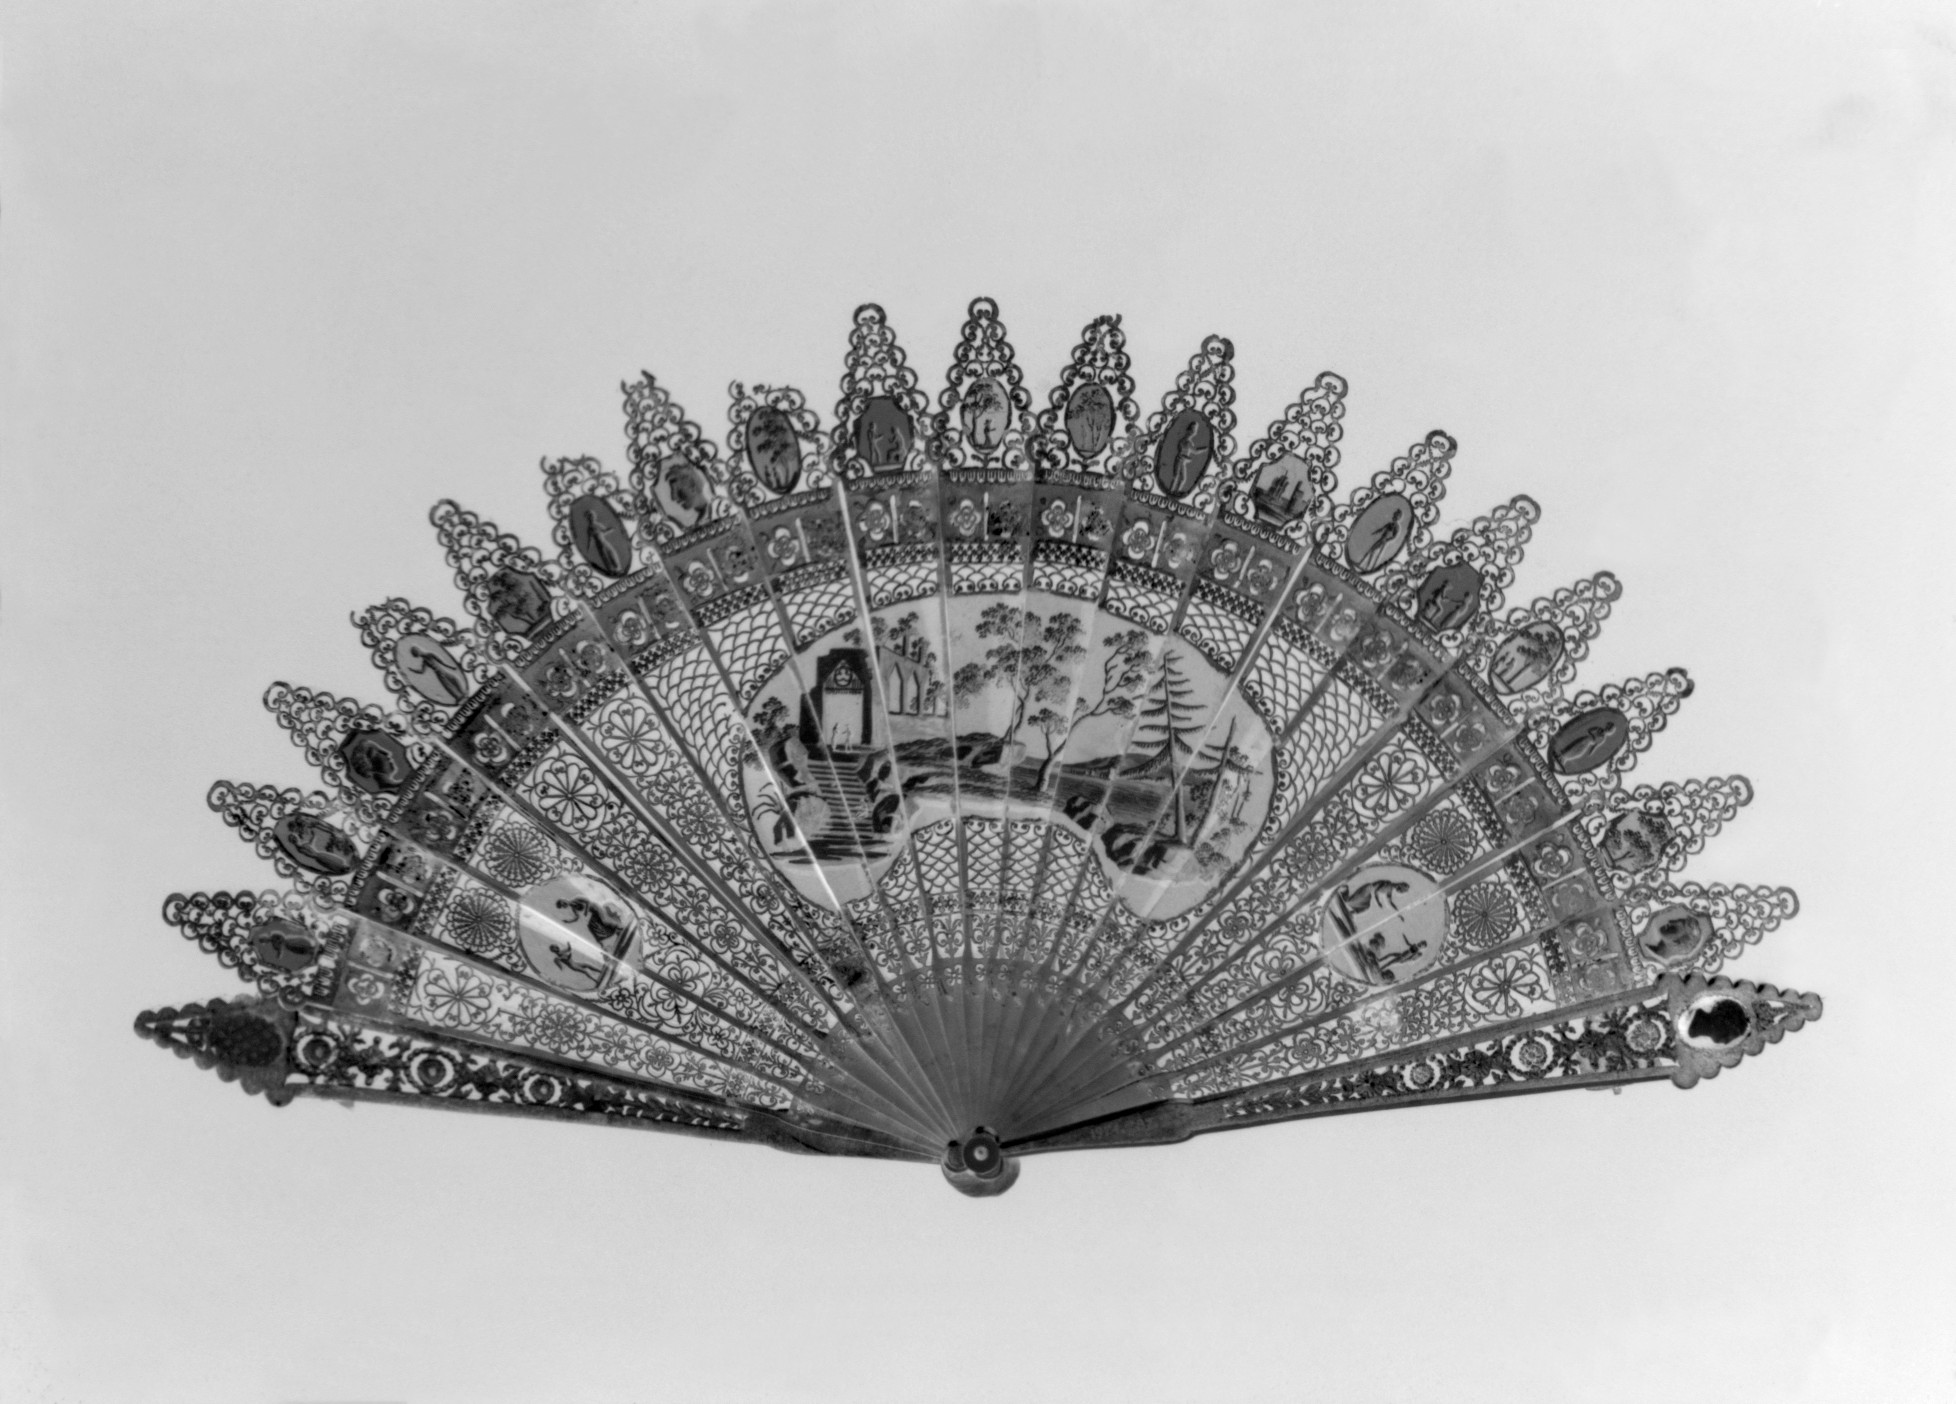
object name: fan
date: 1801-1850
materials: gilt bronze, glass, horn, paint